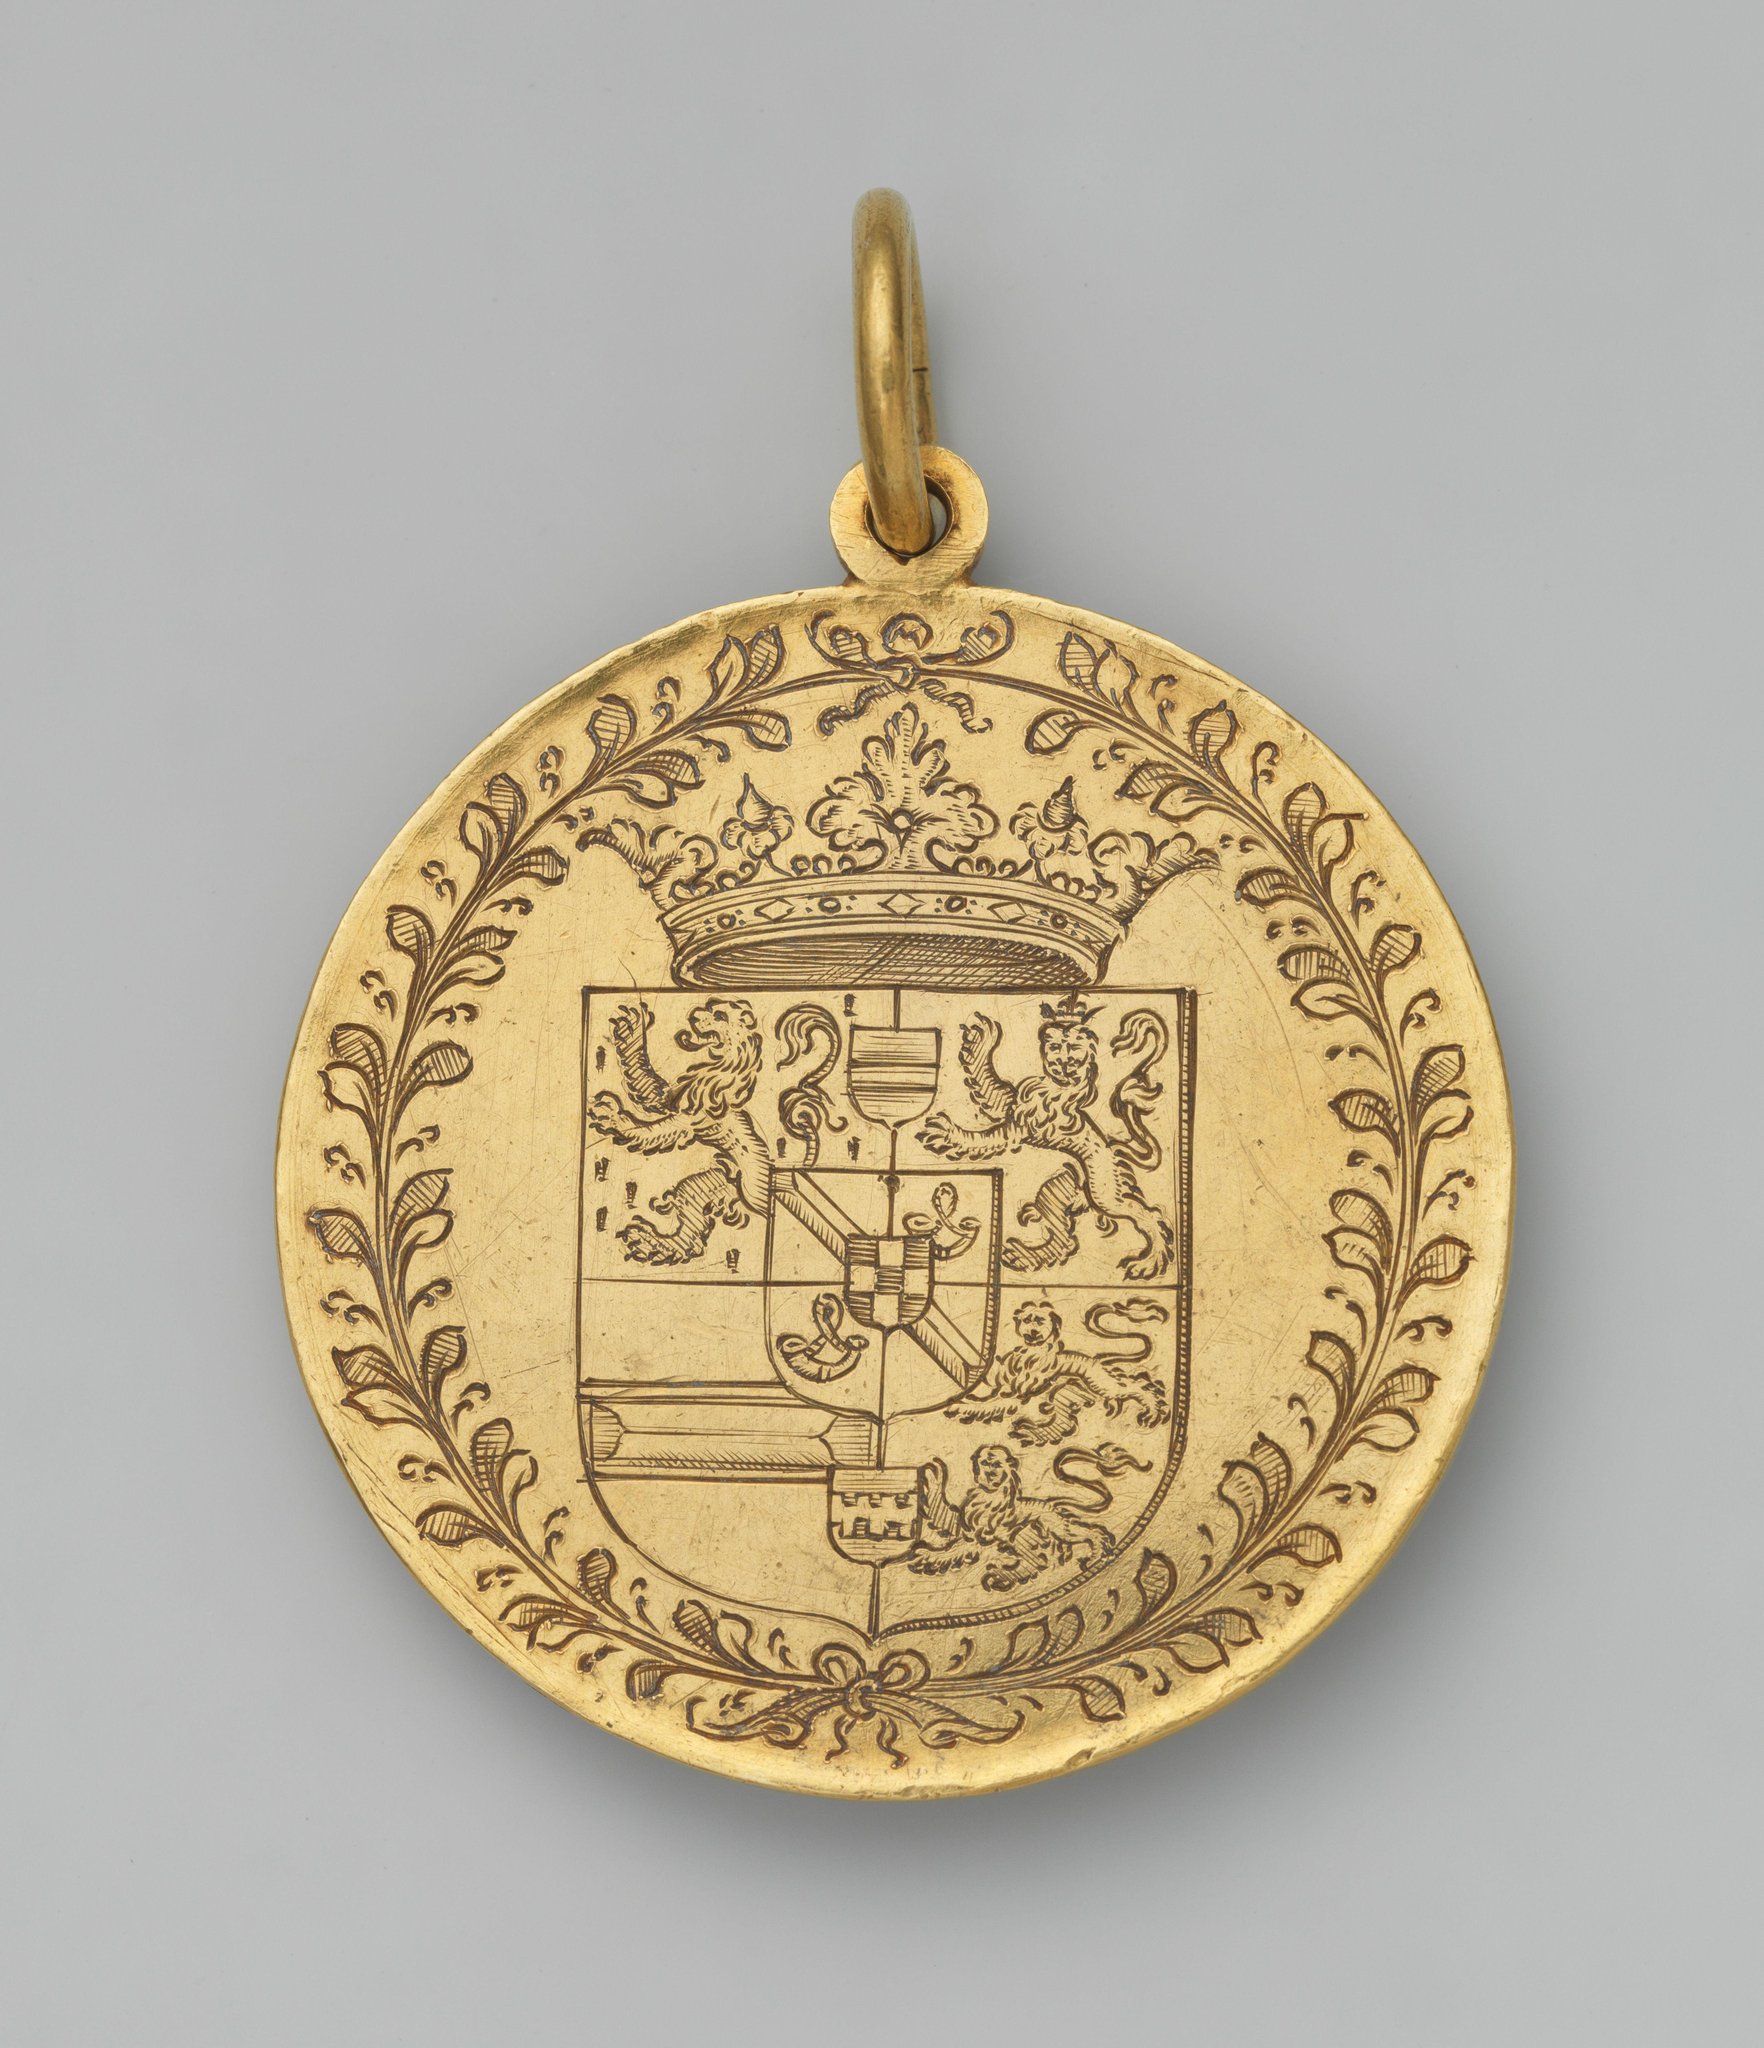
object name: medal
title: Honorary Medal Awarded by Frederick Henry to Piet Hein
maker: Anonymous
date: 1629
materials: gold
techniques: striking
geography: netherlands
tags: delfshaven, coat of arms (symbol of sovereignty), capture of the spanish treasure fleet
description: People who have performed a heroic deed or reached the end of a long career are sometimes awarded a medal as a token of esteem and gratitude. Often these are made of gold. Especially in the seventeenth century, gold medals with their chains were literally a reward. They were subsequently melted down and converted into money, which is why so few have survived.